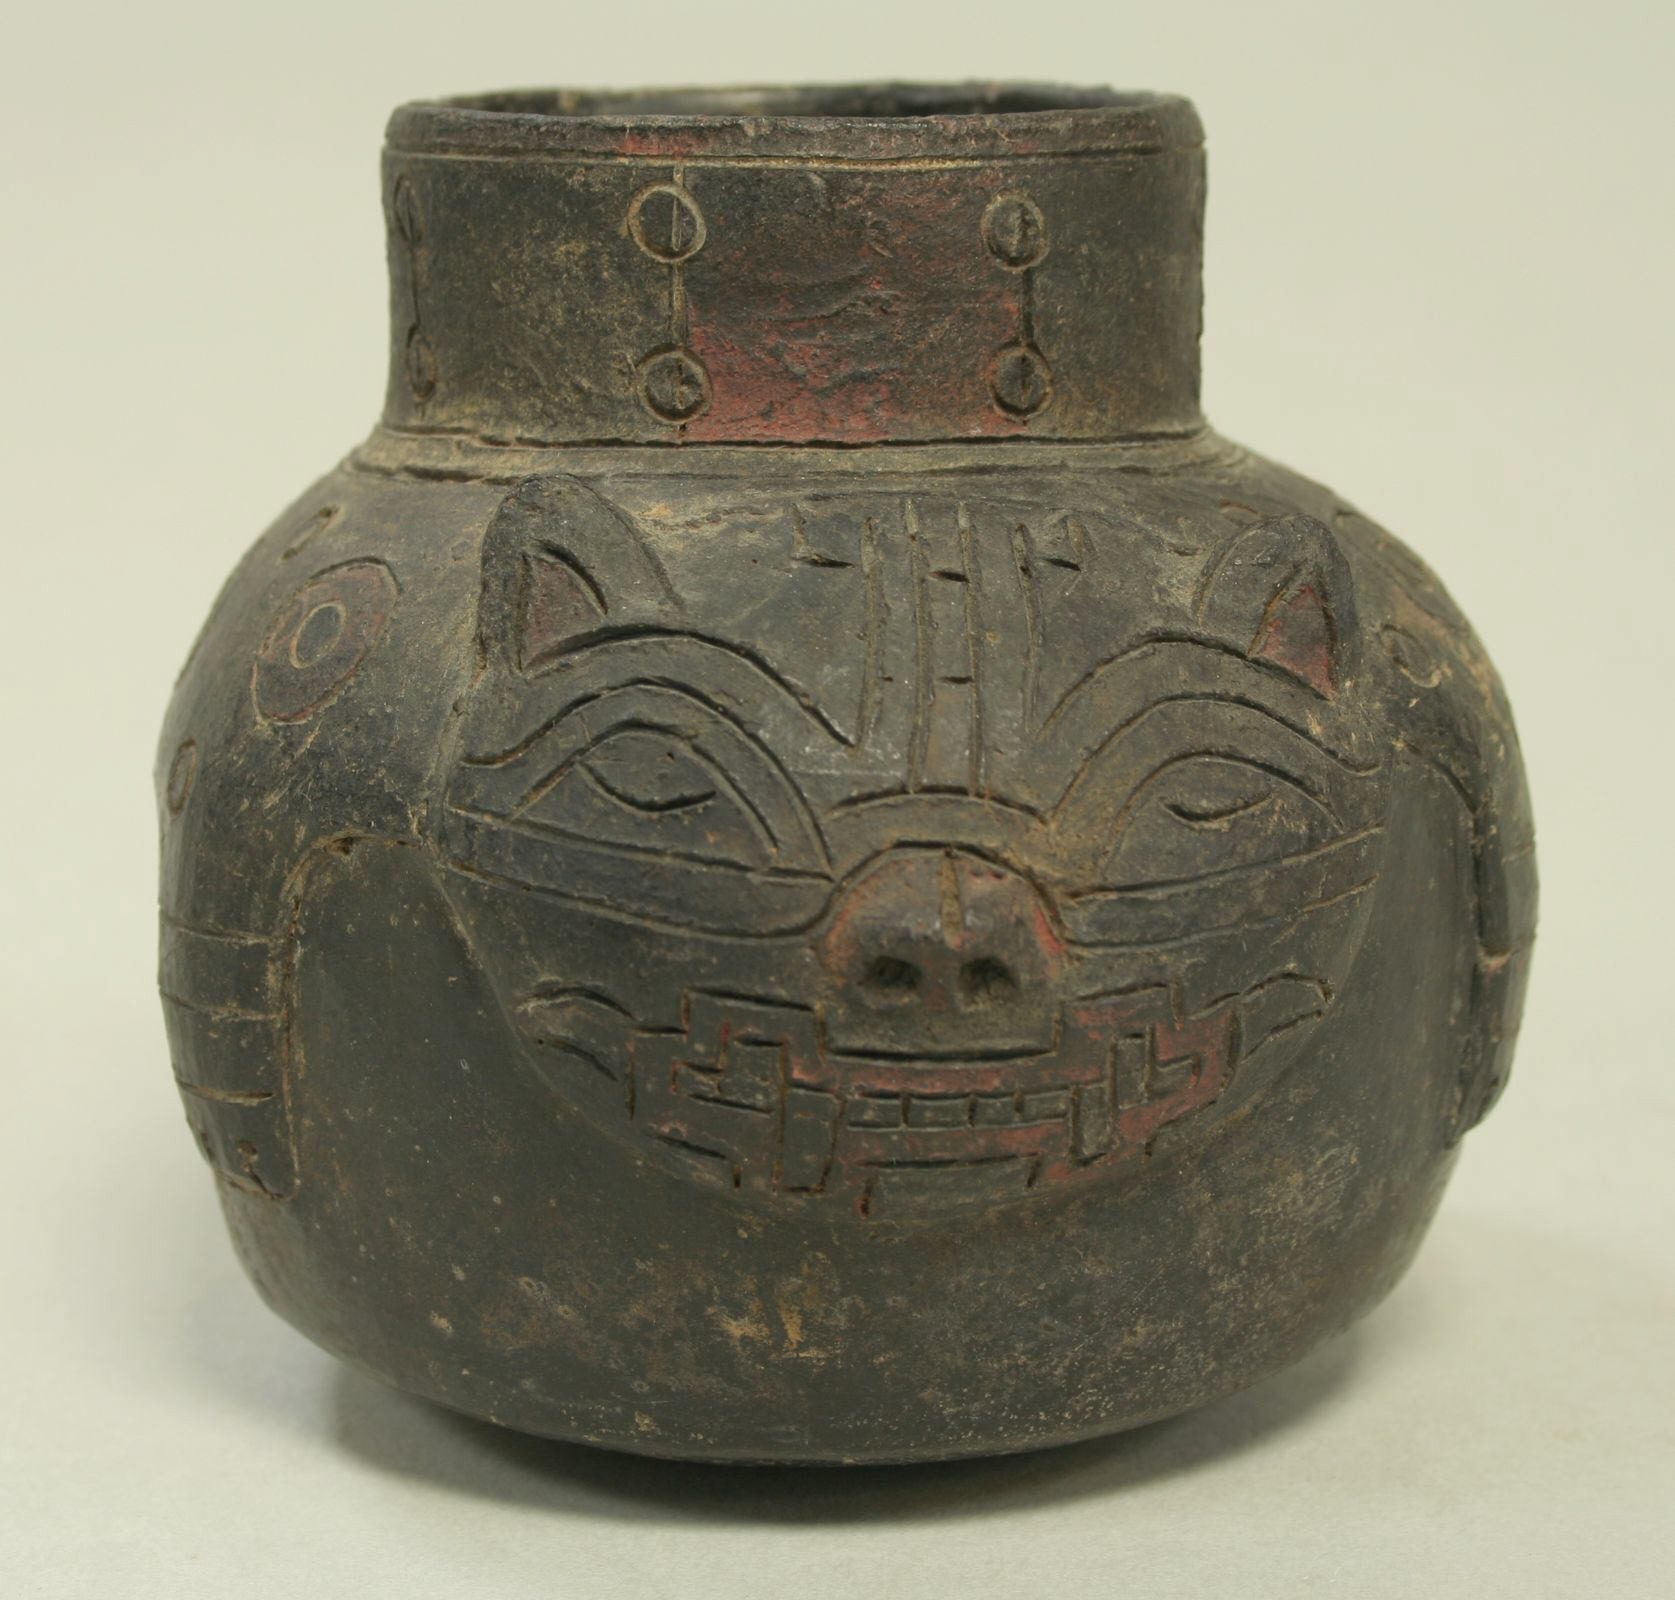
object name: bottle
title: Single Spout Jar in the Form of a Feline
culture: paracas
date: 700-401 BCE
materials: ceramic, pigment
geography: peru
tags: animals